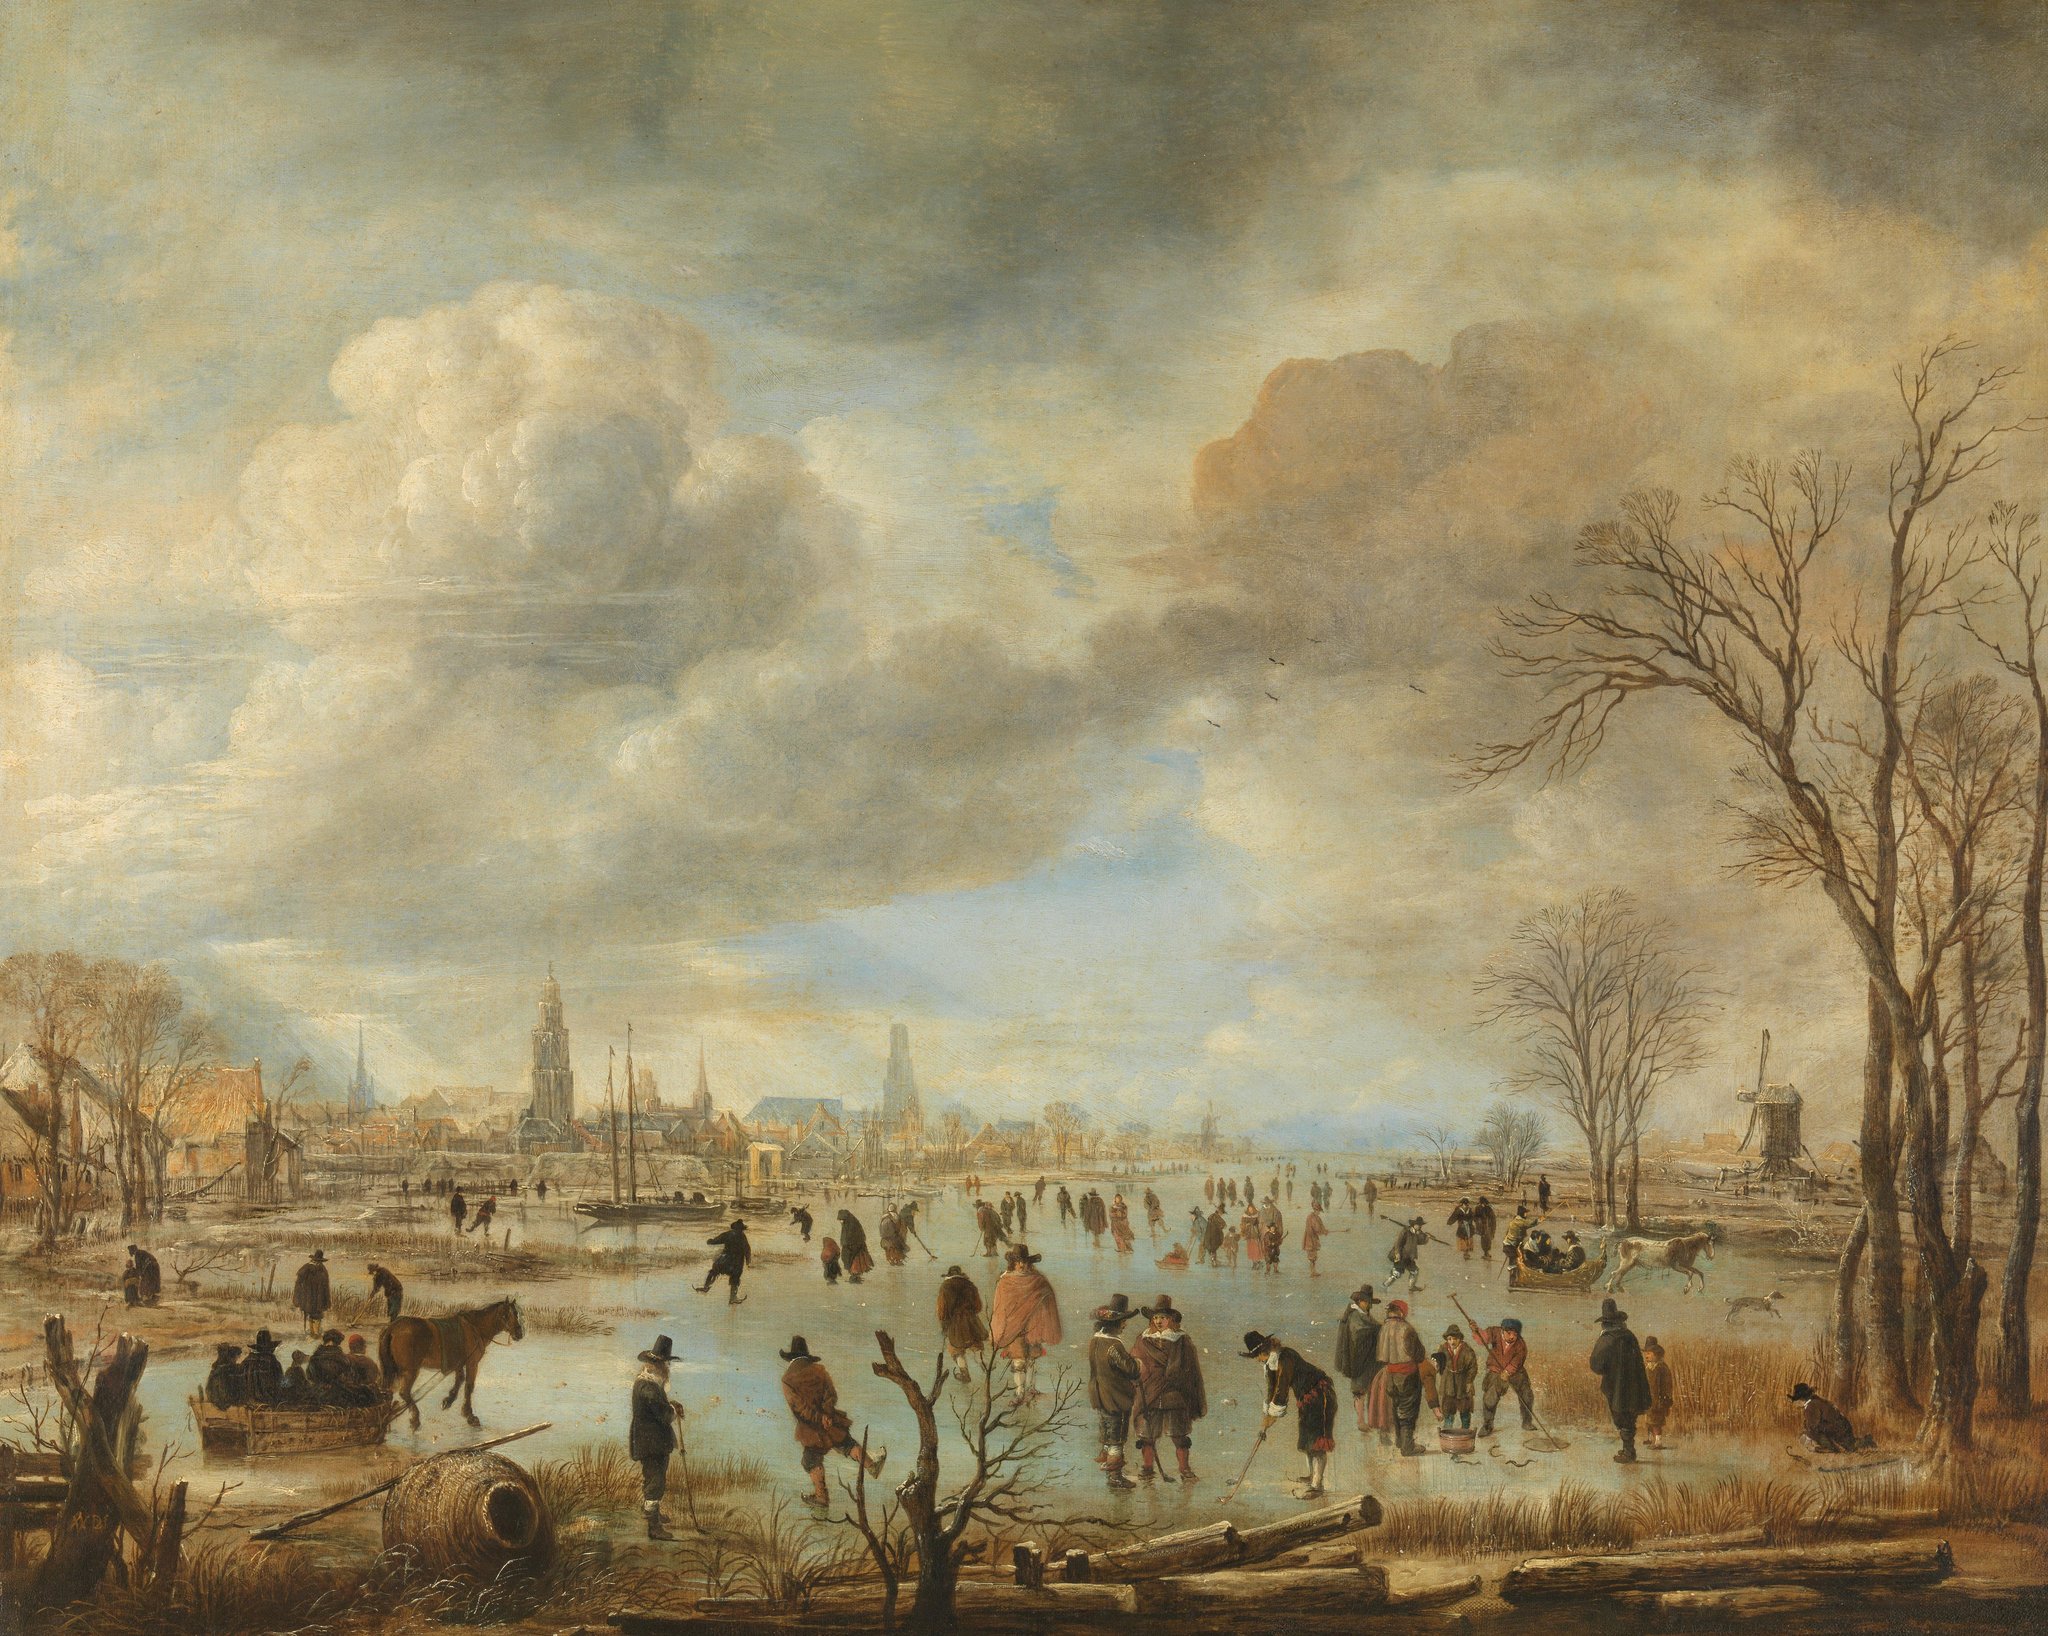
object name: painting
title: Winter Landscape near a Town with Kolf Players and Horse-Drawn Sleighs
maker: aert van der neer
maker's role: painter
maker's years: 1603-1677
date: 1650-1655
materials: canvas, oil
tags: ice ~ freezing weather, winter landscape; landscape symbolizing winter (the four seasons of the year), skates (winter sports), canals, waters (in city), 'kolf' on the ice, sledge, sleigh (winter sports), outskirts of city, prospect of city, town panorama, silhouette of city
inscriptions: signature, with monogram, lower left, on the tree trunk (AV and DN ligated): ‘AV DN’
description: Een typisch Hollands wintergezicht: op het ijs vermaken mensen zich met schaatsen en sleeën. Rechts wordt paling gestoken in een wak. Een groepje mensen speelt ‘kolf’. Dit spel, dat op land en ijs werd gespeeld, was sinds de Middeleeuwen de populairste volkssport van Nederland. Het doel was om met ballen en een soort golfstick de palen van de kolfbaan te raken.